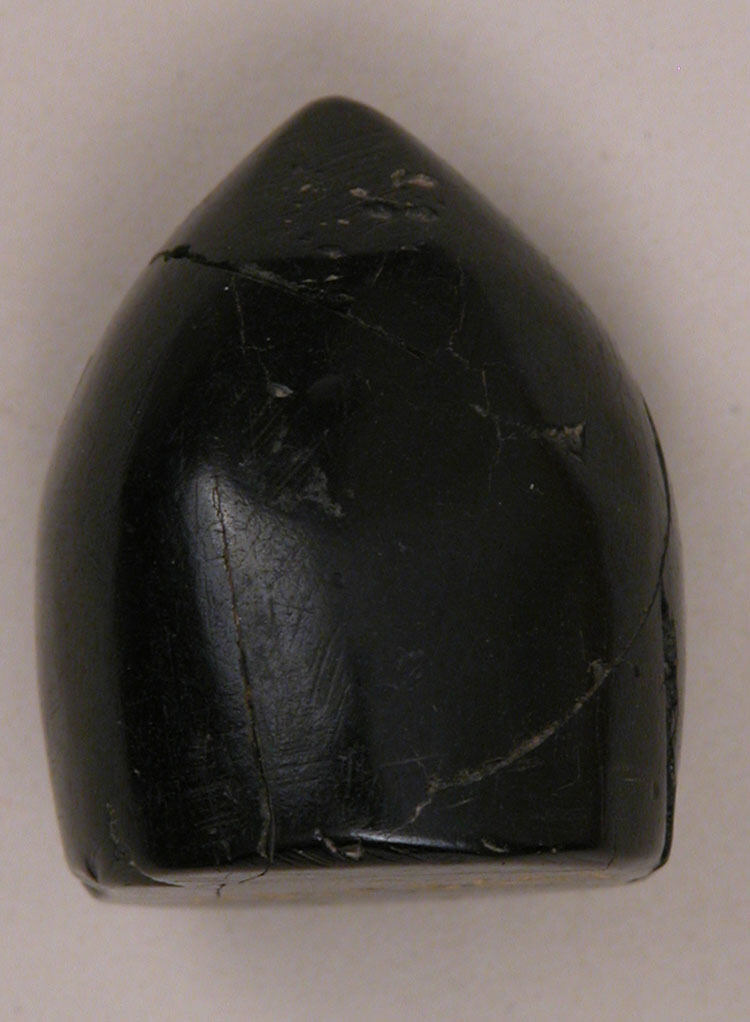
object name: chess piece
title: Chess Piece, probably a Pawn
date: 801-1100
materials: stone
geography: western islamic lands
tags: chess,games